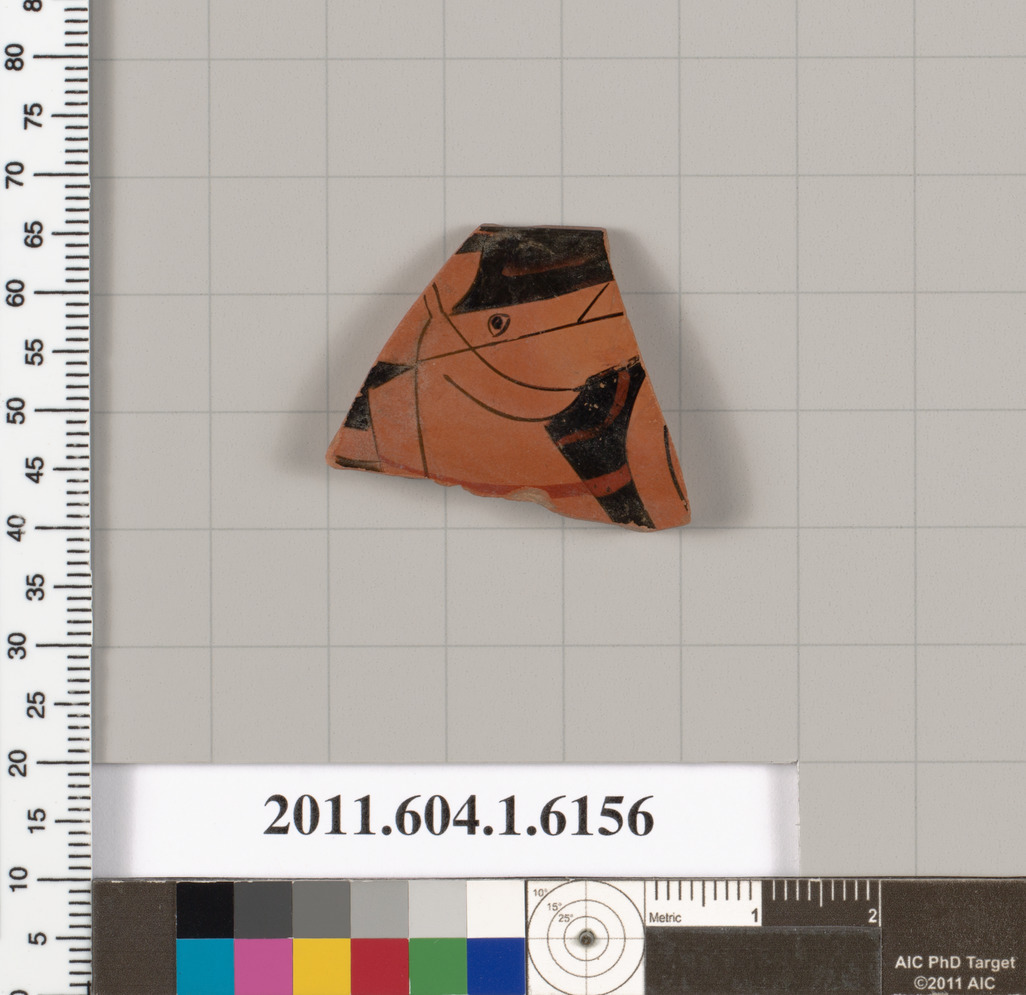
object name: kylix fragment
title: Terracotta rim fragment of a kylix (drinking cup)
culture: greek, attic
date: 520-500 BCE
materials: terracotta